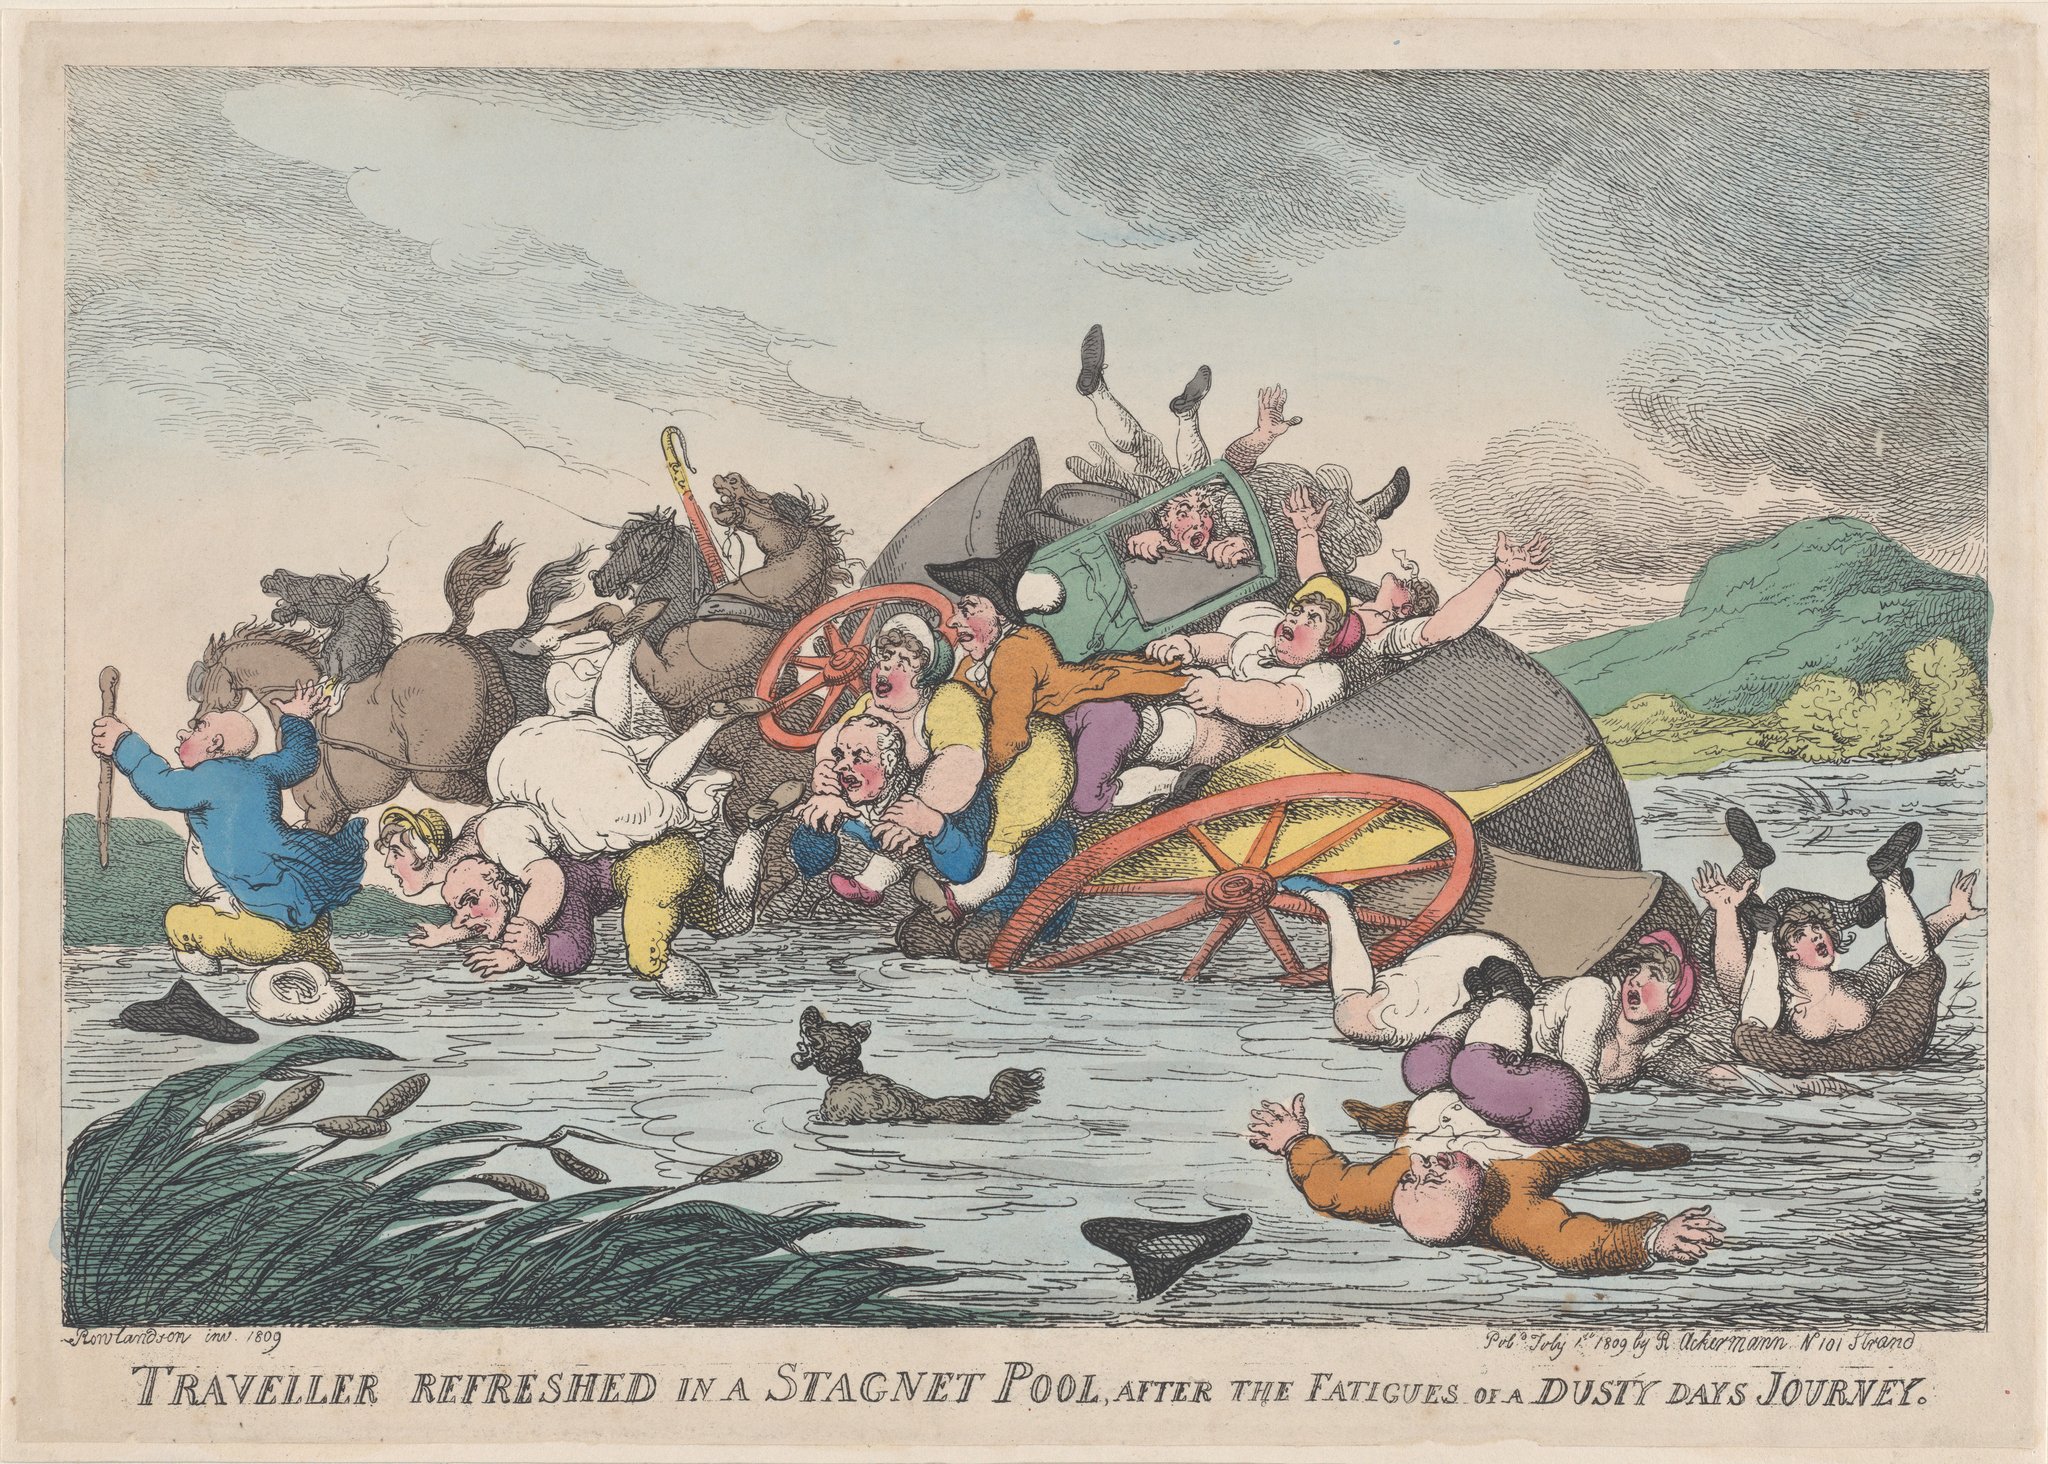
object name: print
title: Traveller Refreshed in a Stagnant Pool, after the Fatigues of a Dusty Day's Journey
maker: thomas rowlandson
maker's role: artist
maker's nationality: british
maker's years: 1757-1827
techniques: etching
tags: satire,men,women,carriages